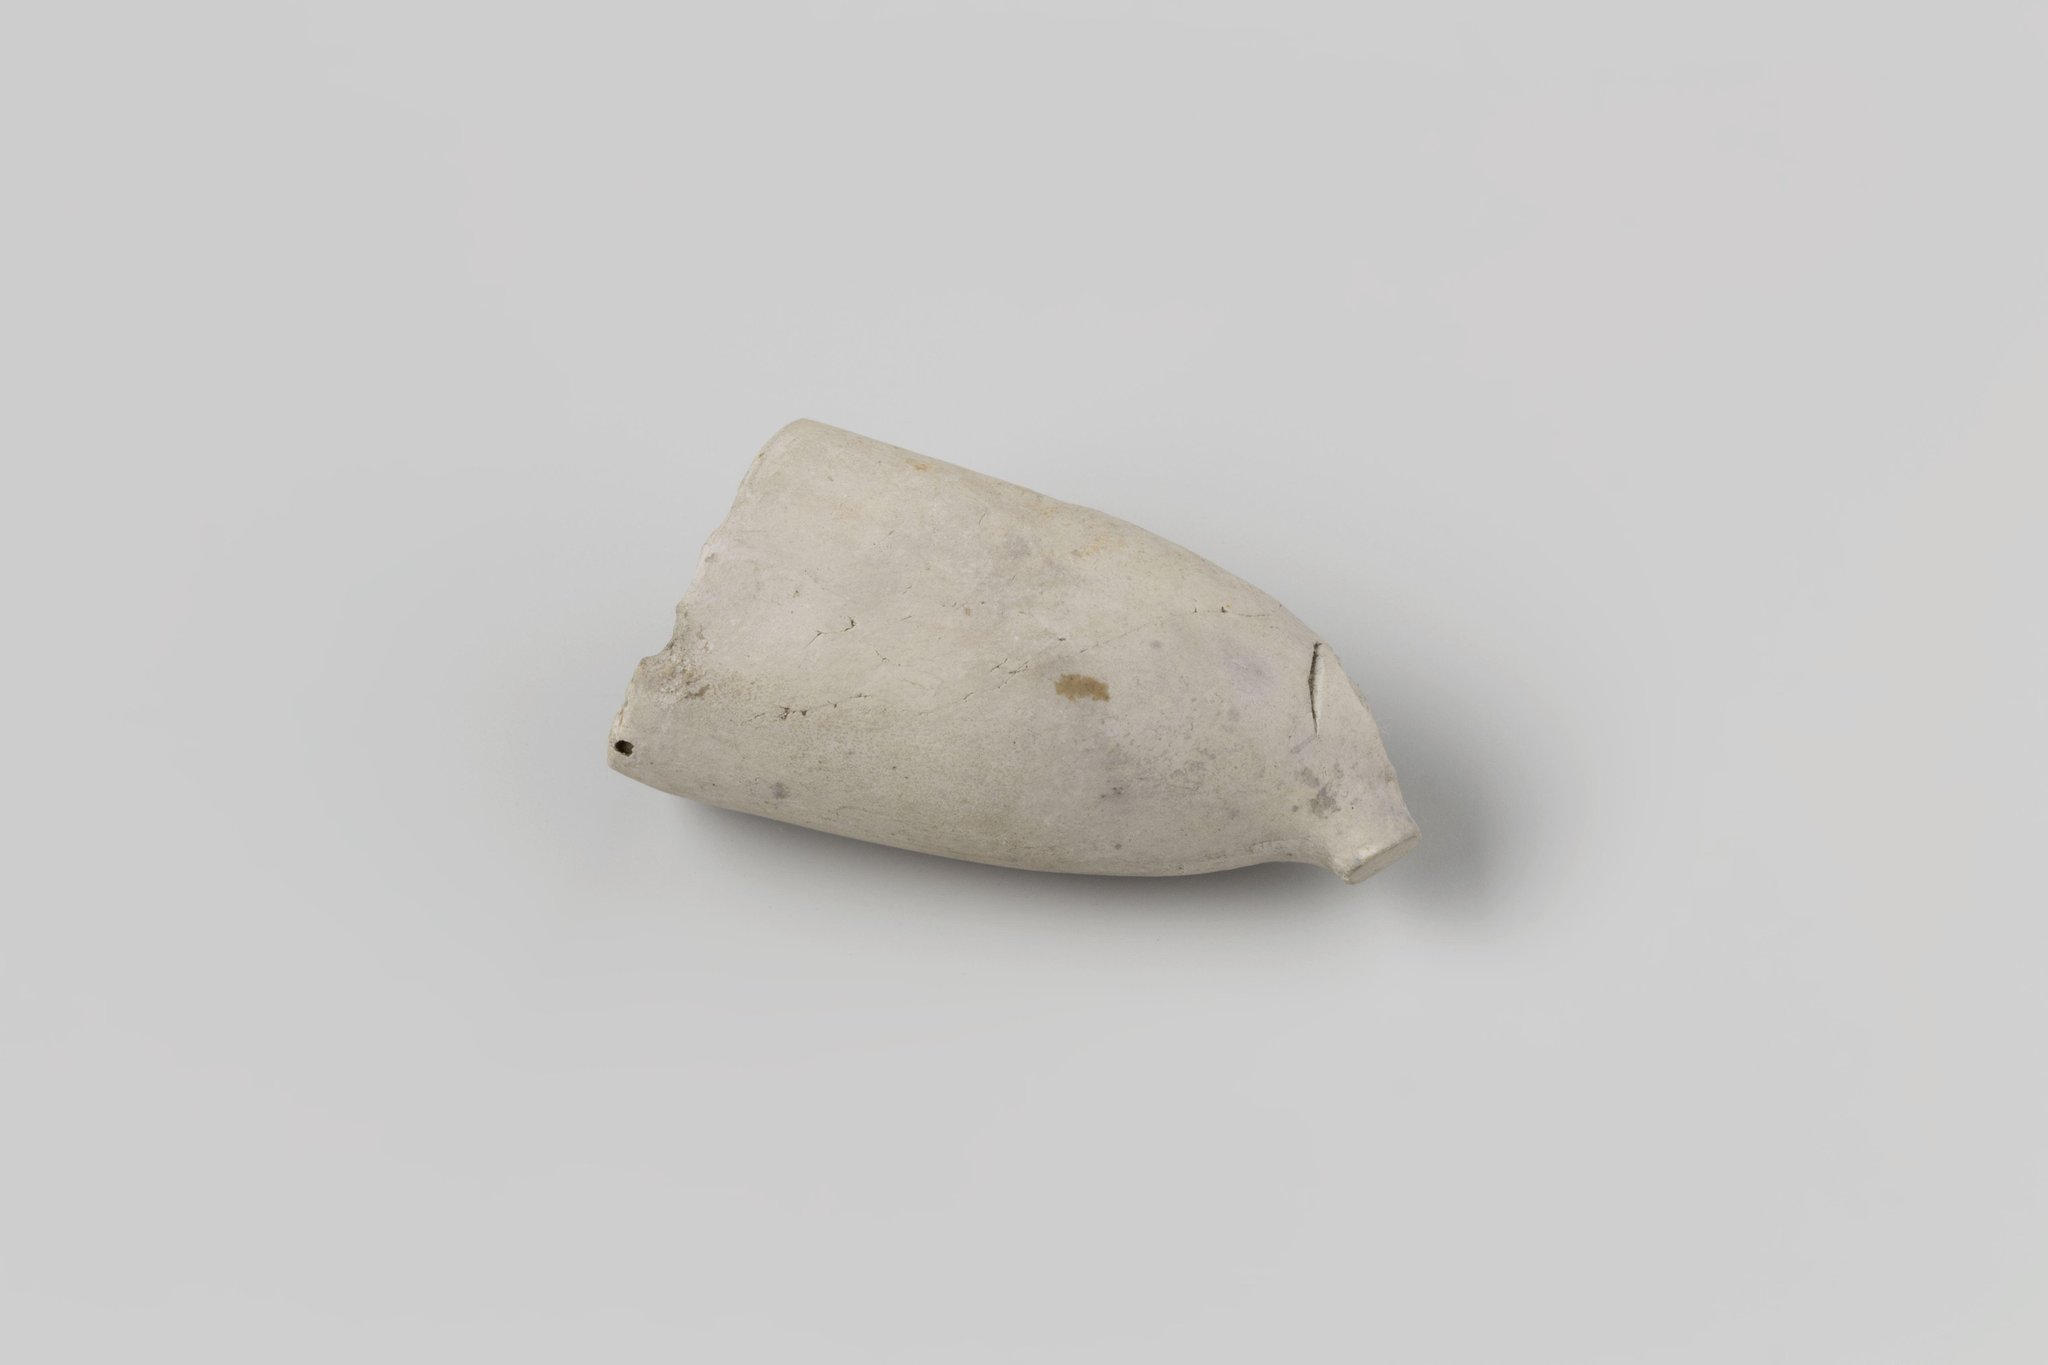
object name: fragment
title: Fragment van een tabakspijp.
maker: Anonymous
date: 1400-1950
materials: earthenware, clay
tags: loevestein castle